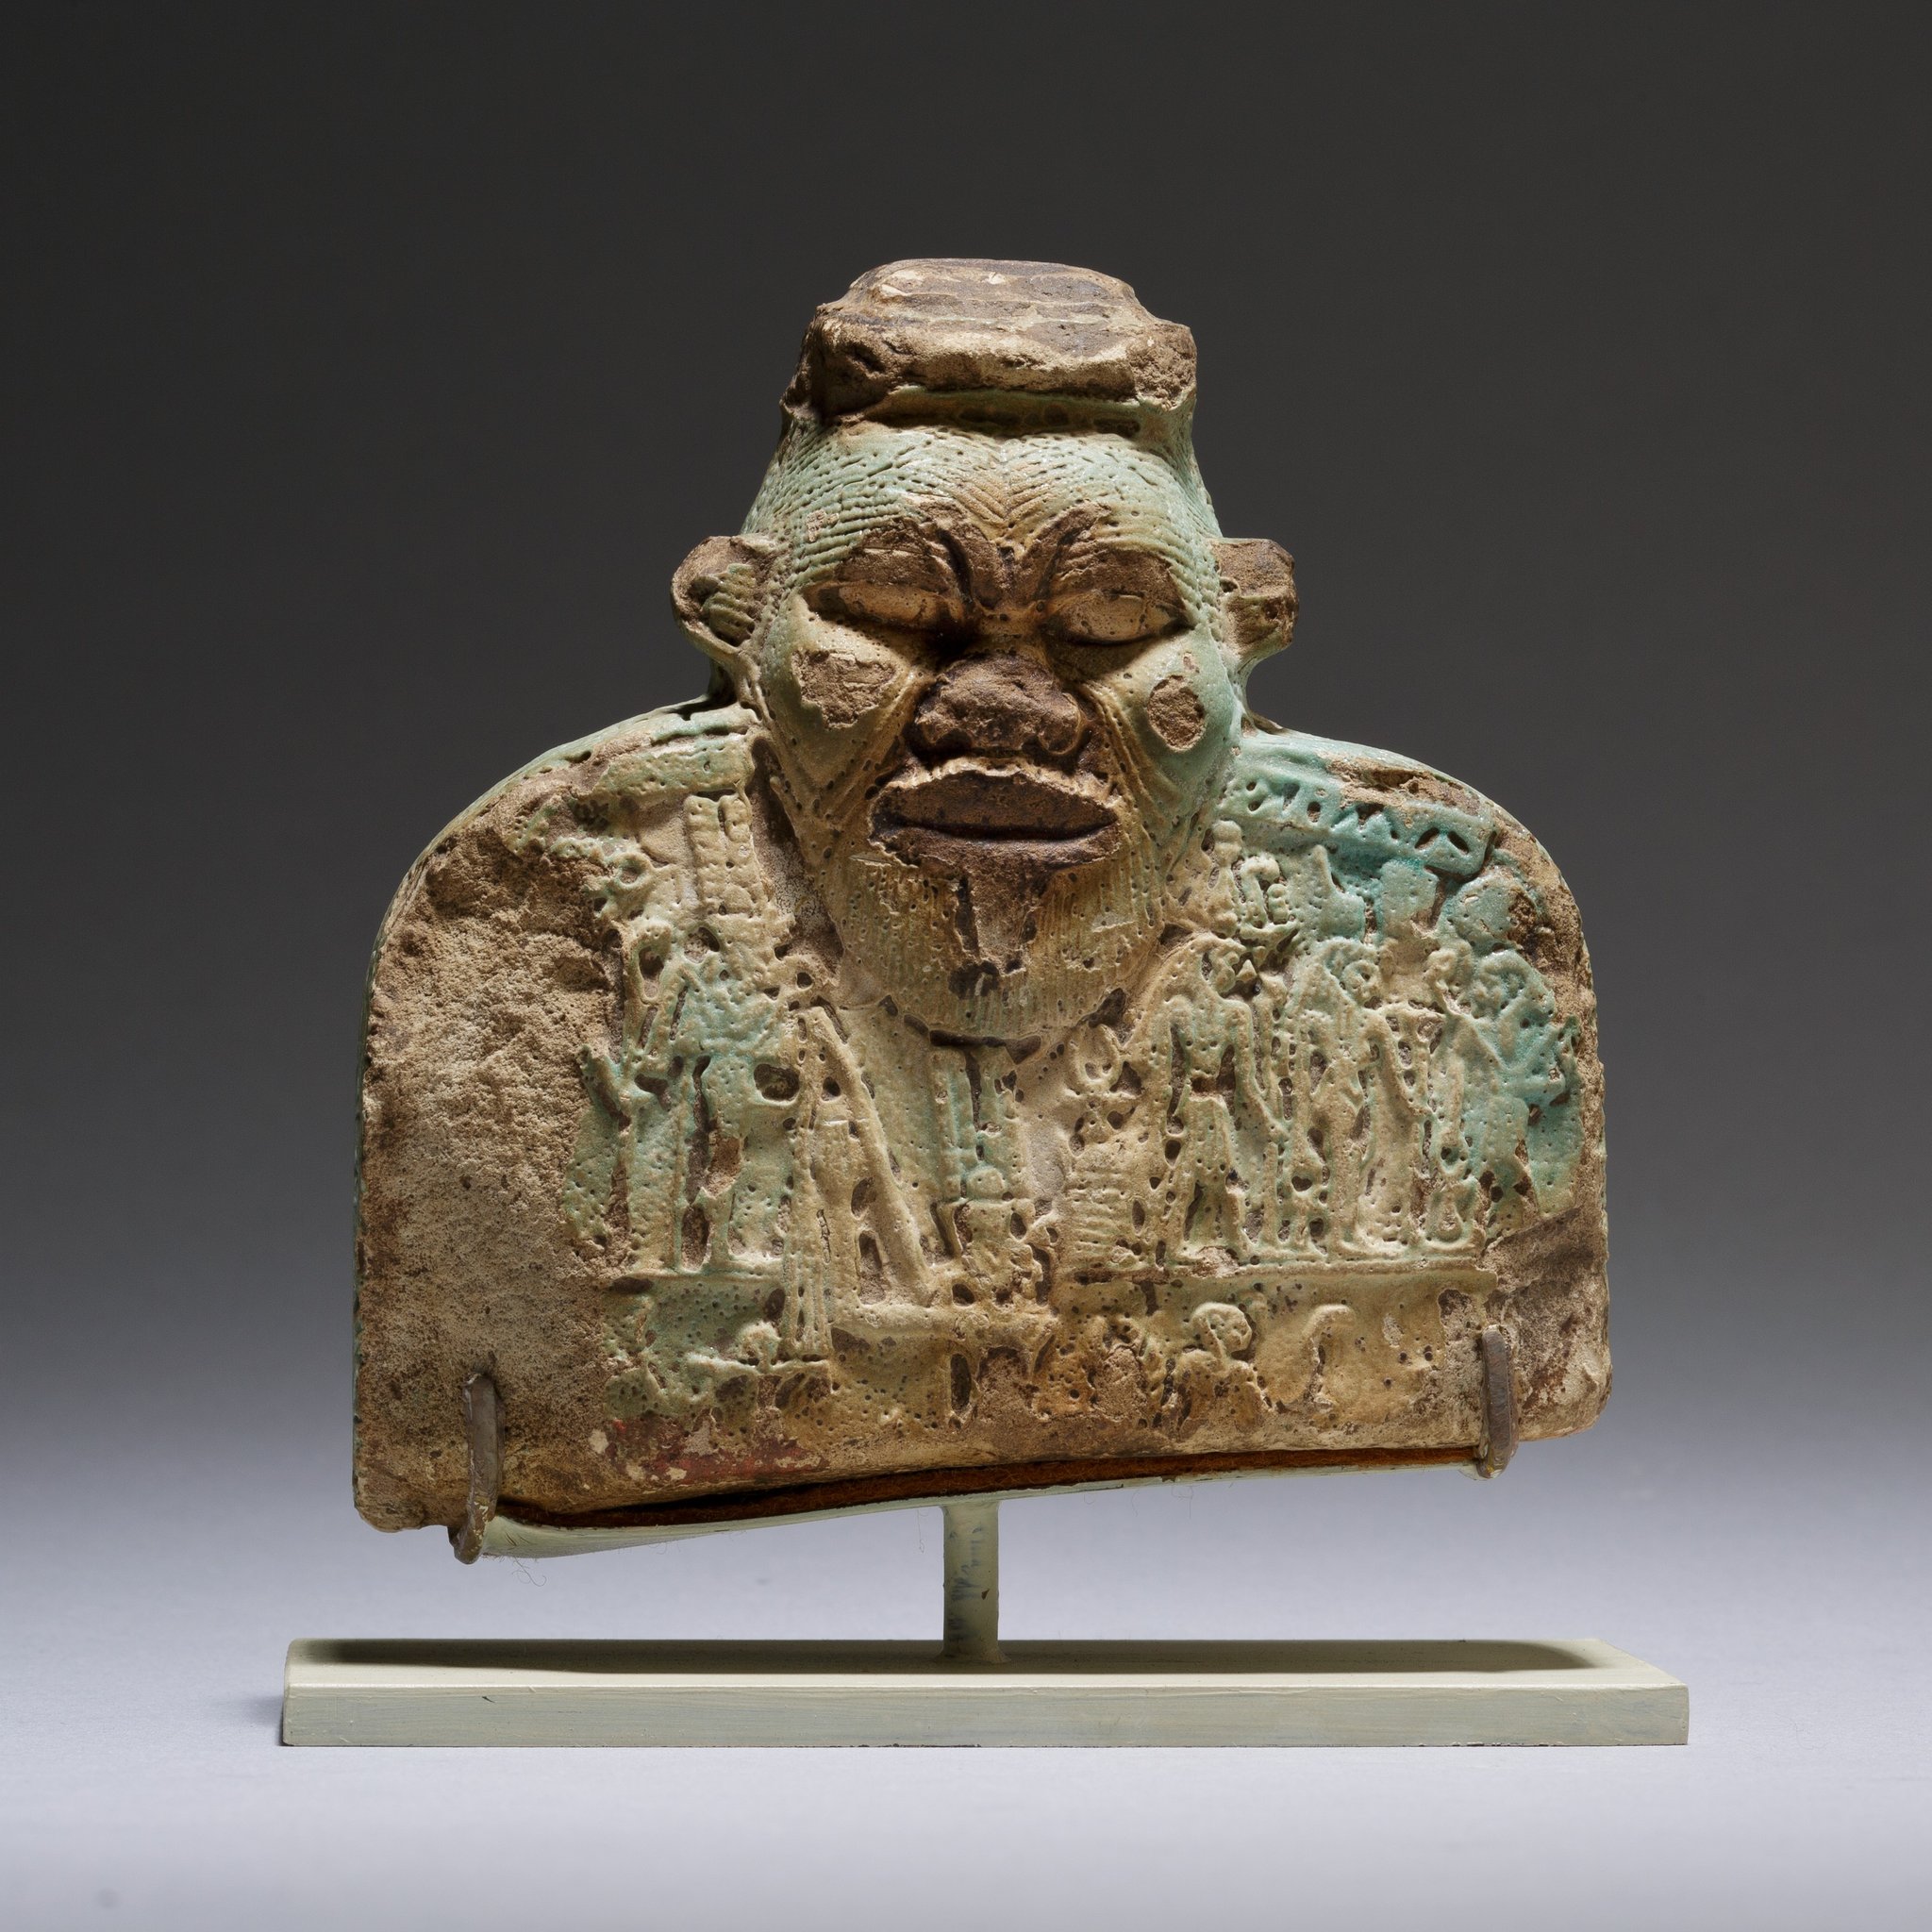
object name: cippus, be head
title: Cippus (magical stela)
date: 664-380 BCE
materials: faience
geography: egypt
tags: men